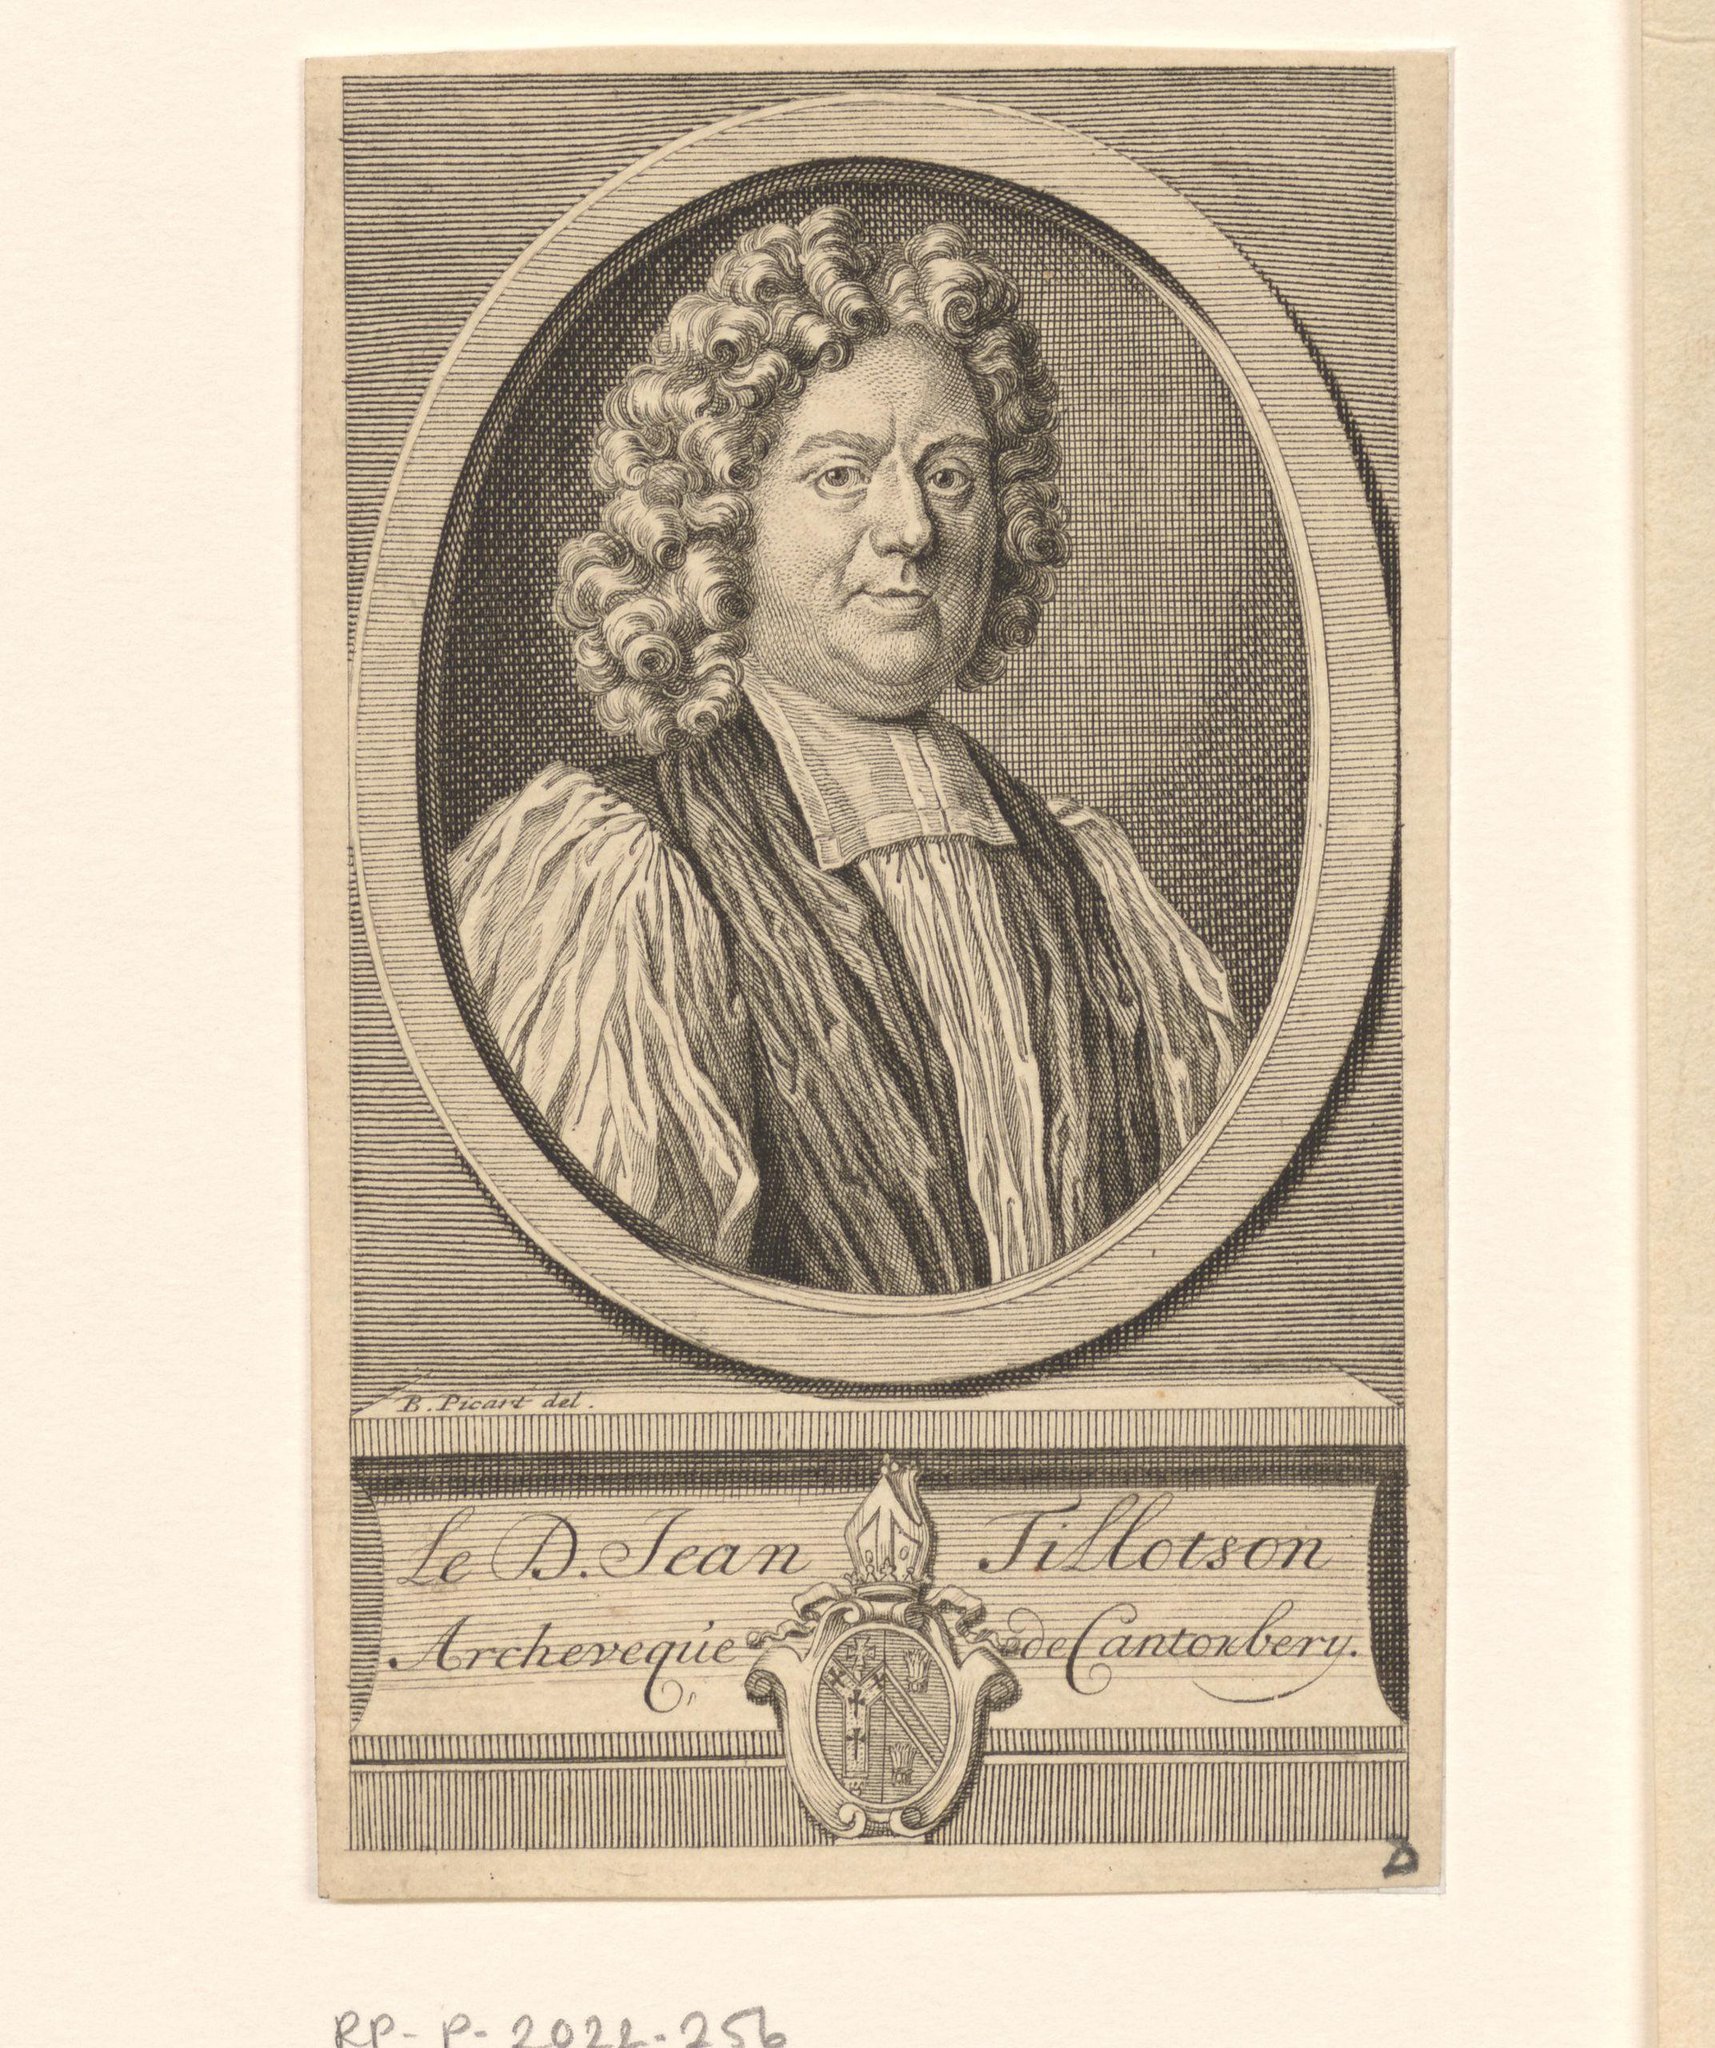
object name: print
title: Portret van John Tillotson, aartsbisschop van Canterbury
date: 1683-1733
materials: paper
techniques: engraving, etching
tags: archbishop, bishop, etc. (roman catholic), historical persons, armorial bearing, heraldry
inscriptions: collector's mark: Lugt 240